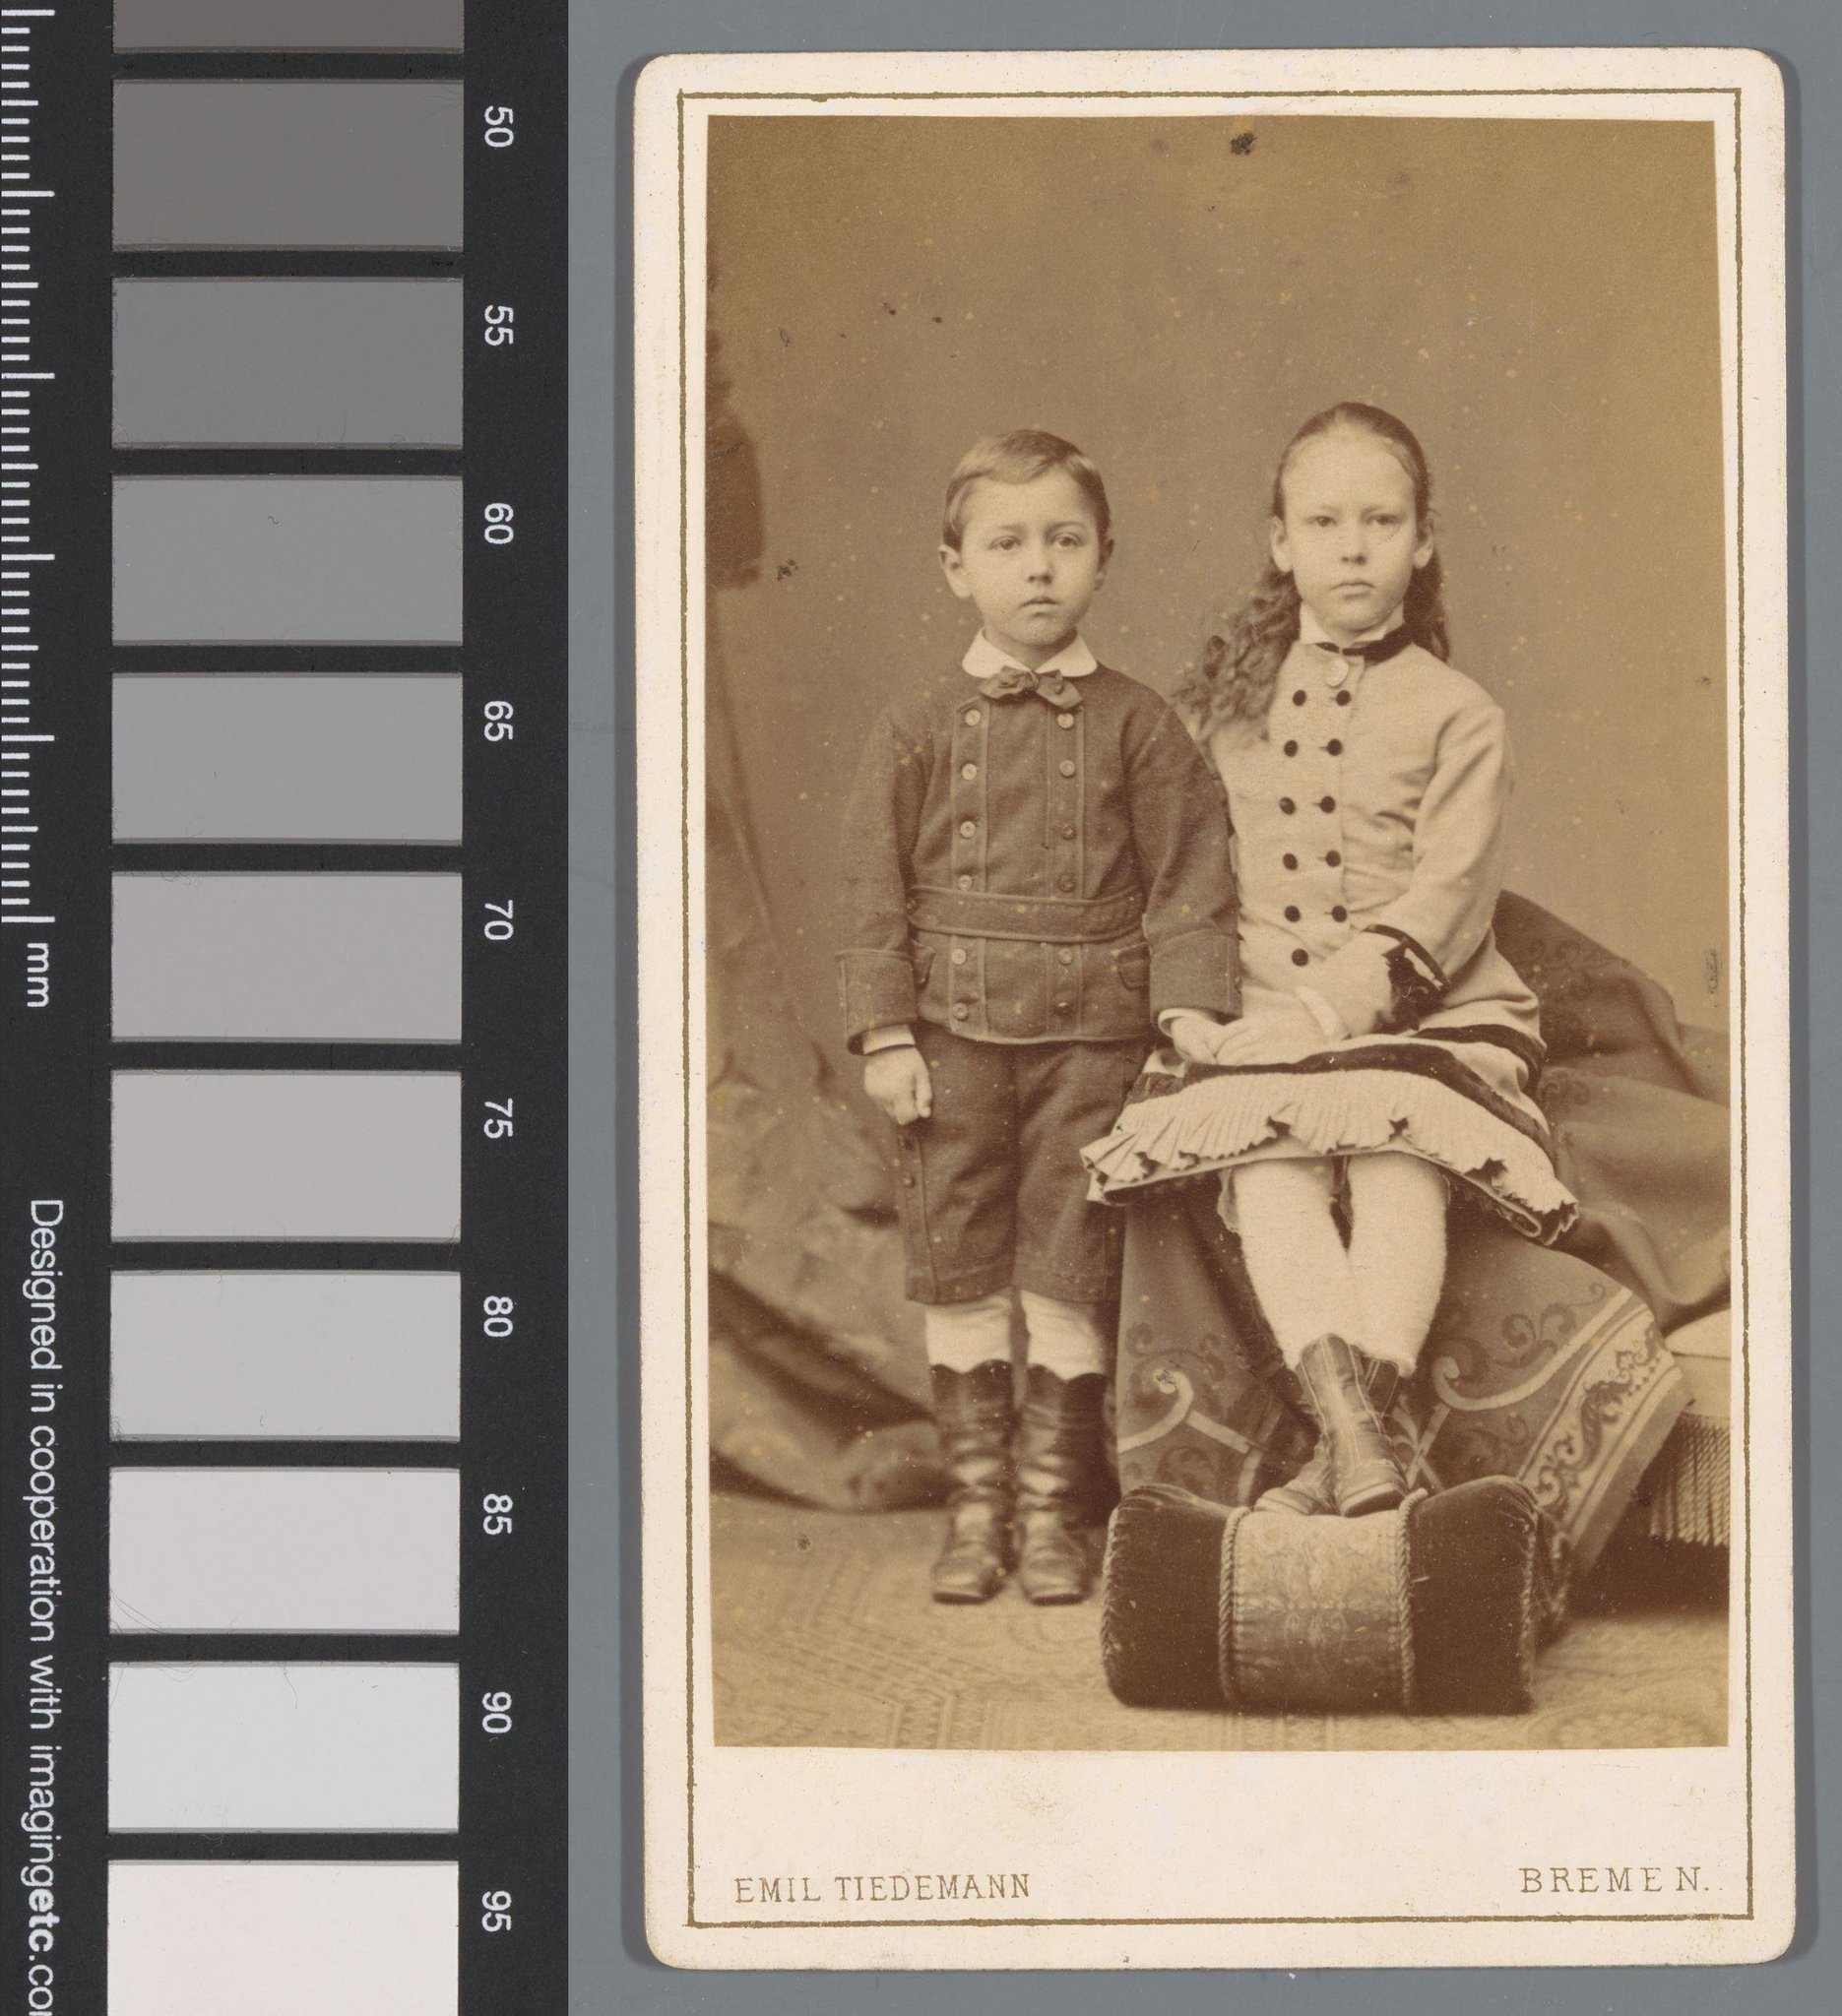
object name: carte de visite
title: Portret van een onbekende jongen en meisje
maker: emil thiedemann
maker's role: fotograaf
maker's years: 1858-1897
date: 1866-1885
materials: cardboard, paper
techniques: albumen print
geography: bremen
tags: boy (child between toddler and youth), girl (child between toddler and youth), anonymous historical person portrayed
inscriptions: inscription: ‘Für Nachbestellungen bleibt/ die Platte aufbewahrt.’, address: ‘12, Richtweg 12./ BREMEN.’